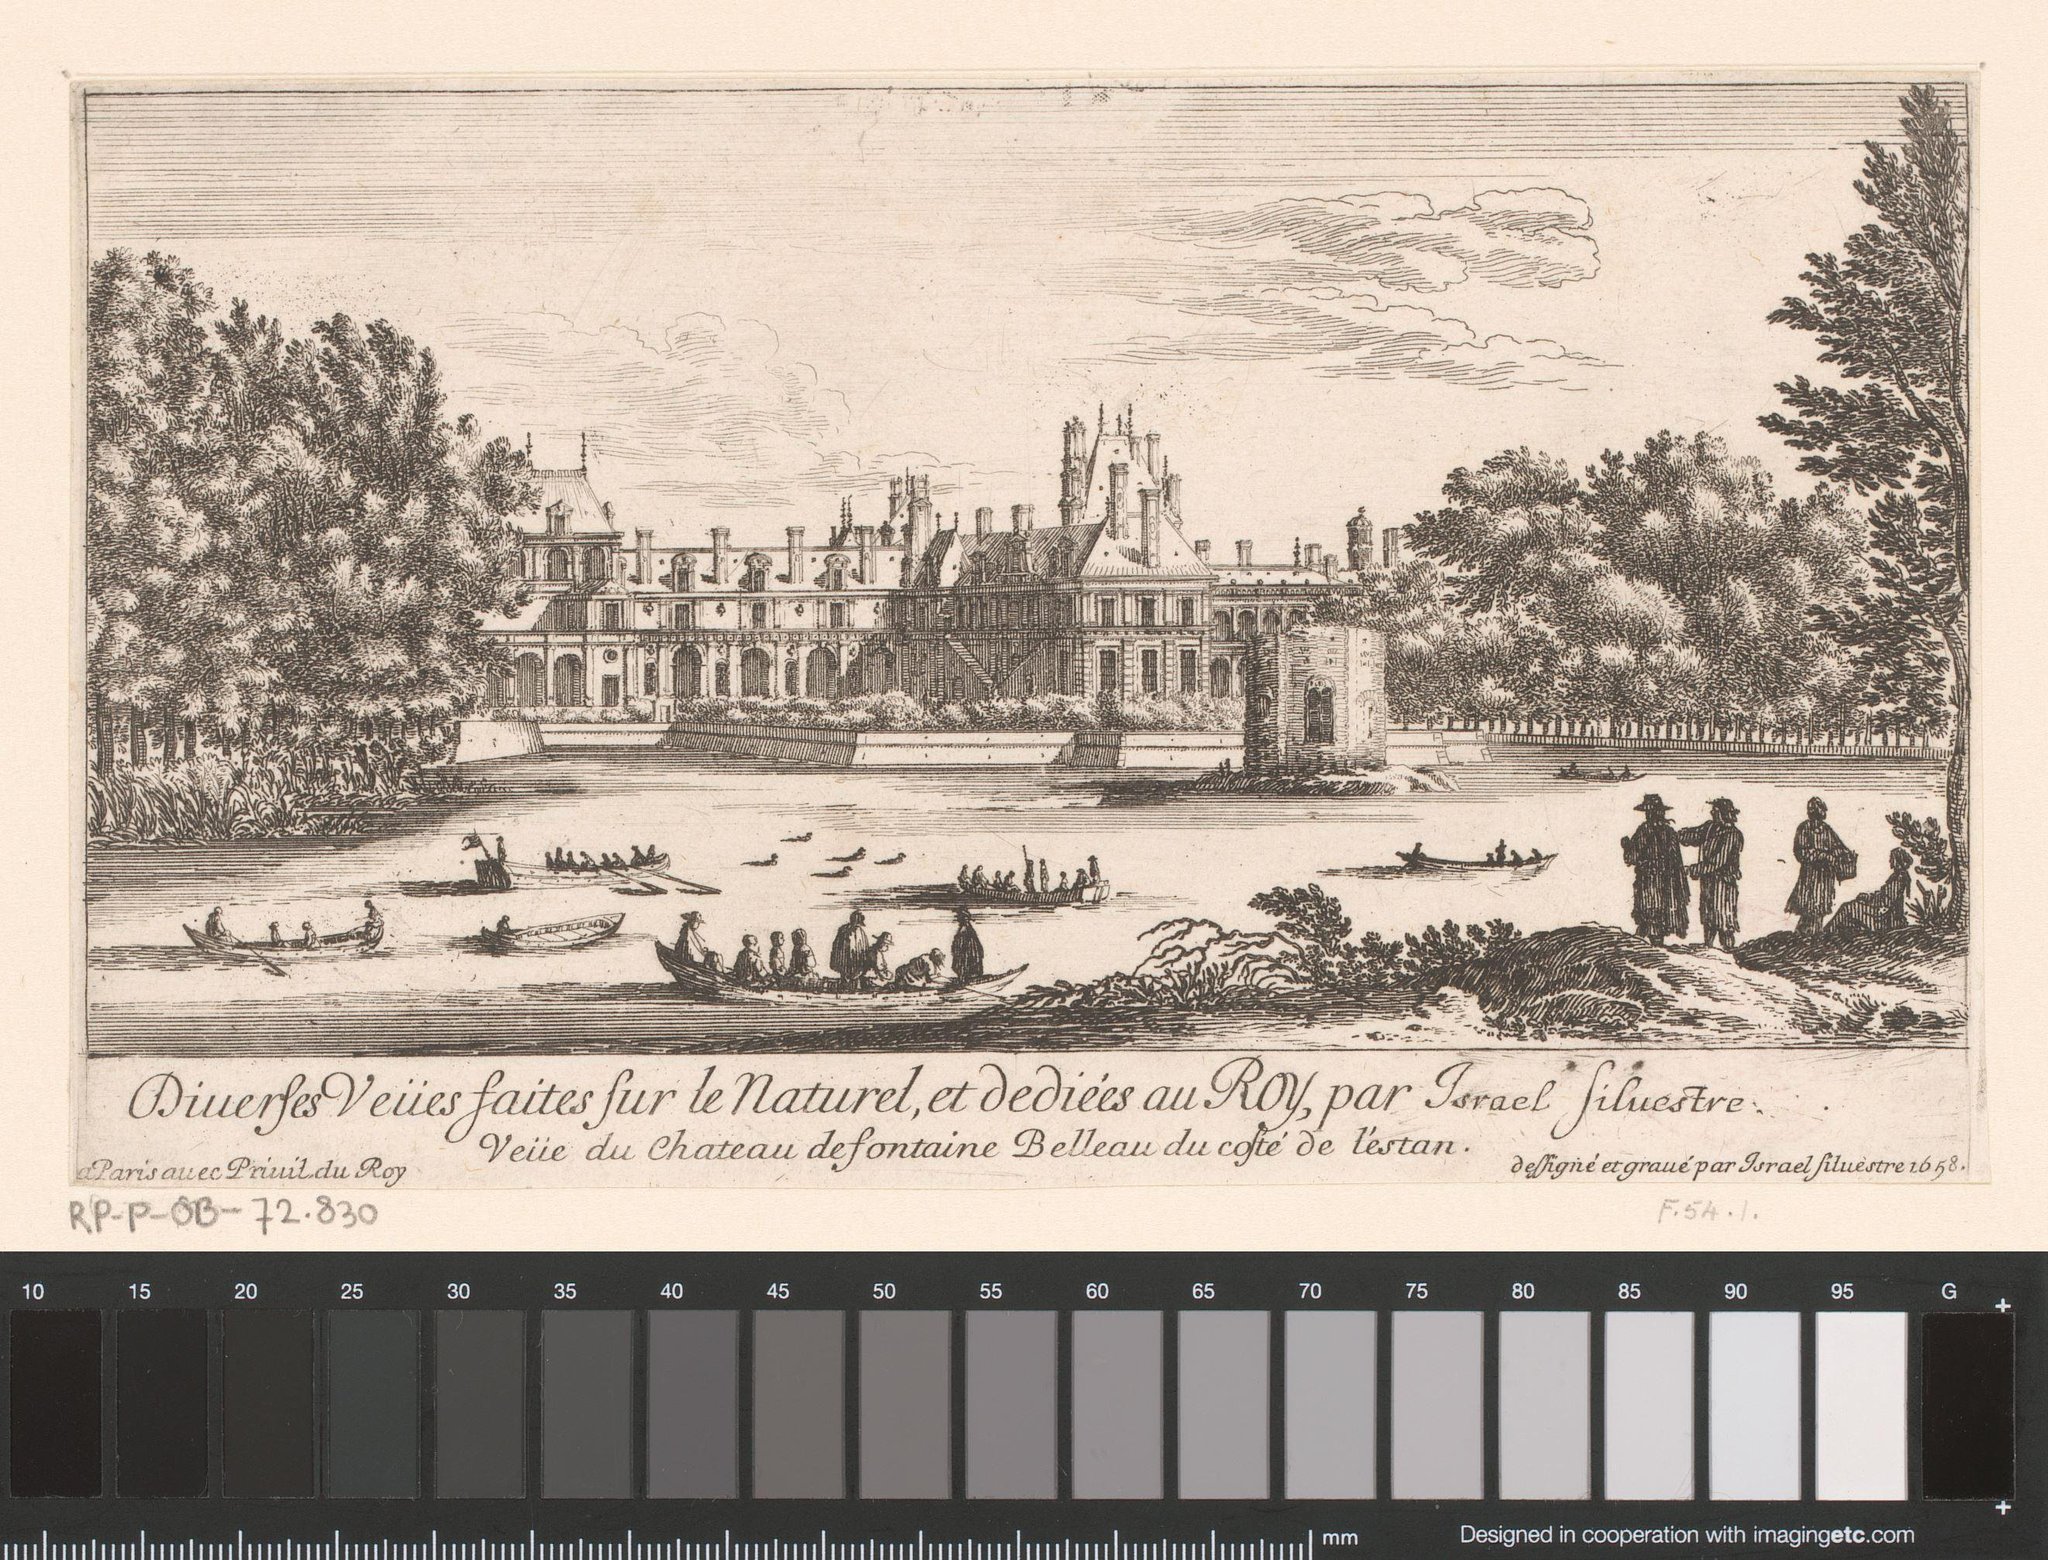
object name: titelprent, frontispice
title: Veue du Chateau de fontaine Belleau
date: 1658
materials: paper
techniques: etching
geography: france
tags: landscape with tower or castle (+ city(-scape) with figures, staffage)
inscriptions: collector's mark: Lugt 240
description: Prent maakt deel uit van een ongenummerde serie van tien prenten.